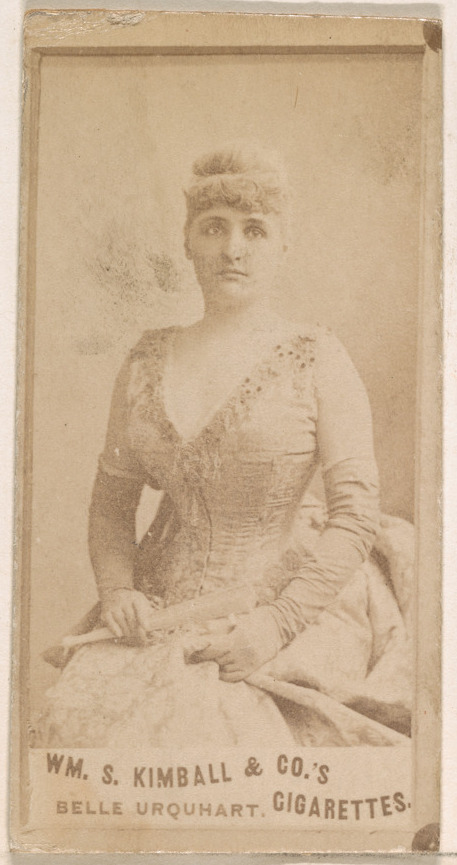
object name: photograph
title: Belle Urquhart, from the Actresses series (N203) issued by Wm. S. Kimball & Co.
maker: william s. kimball & company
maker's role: publisher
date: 1889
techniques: color lithograph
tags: portraits,women,actresses